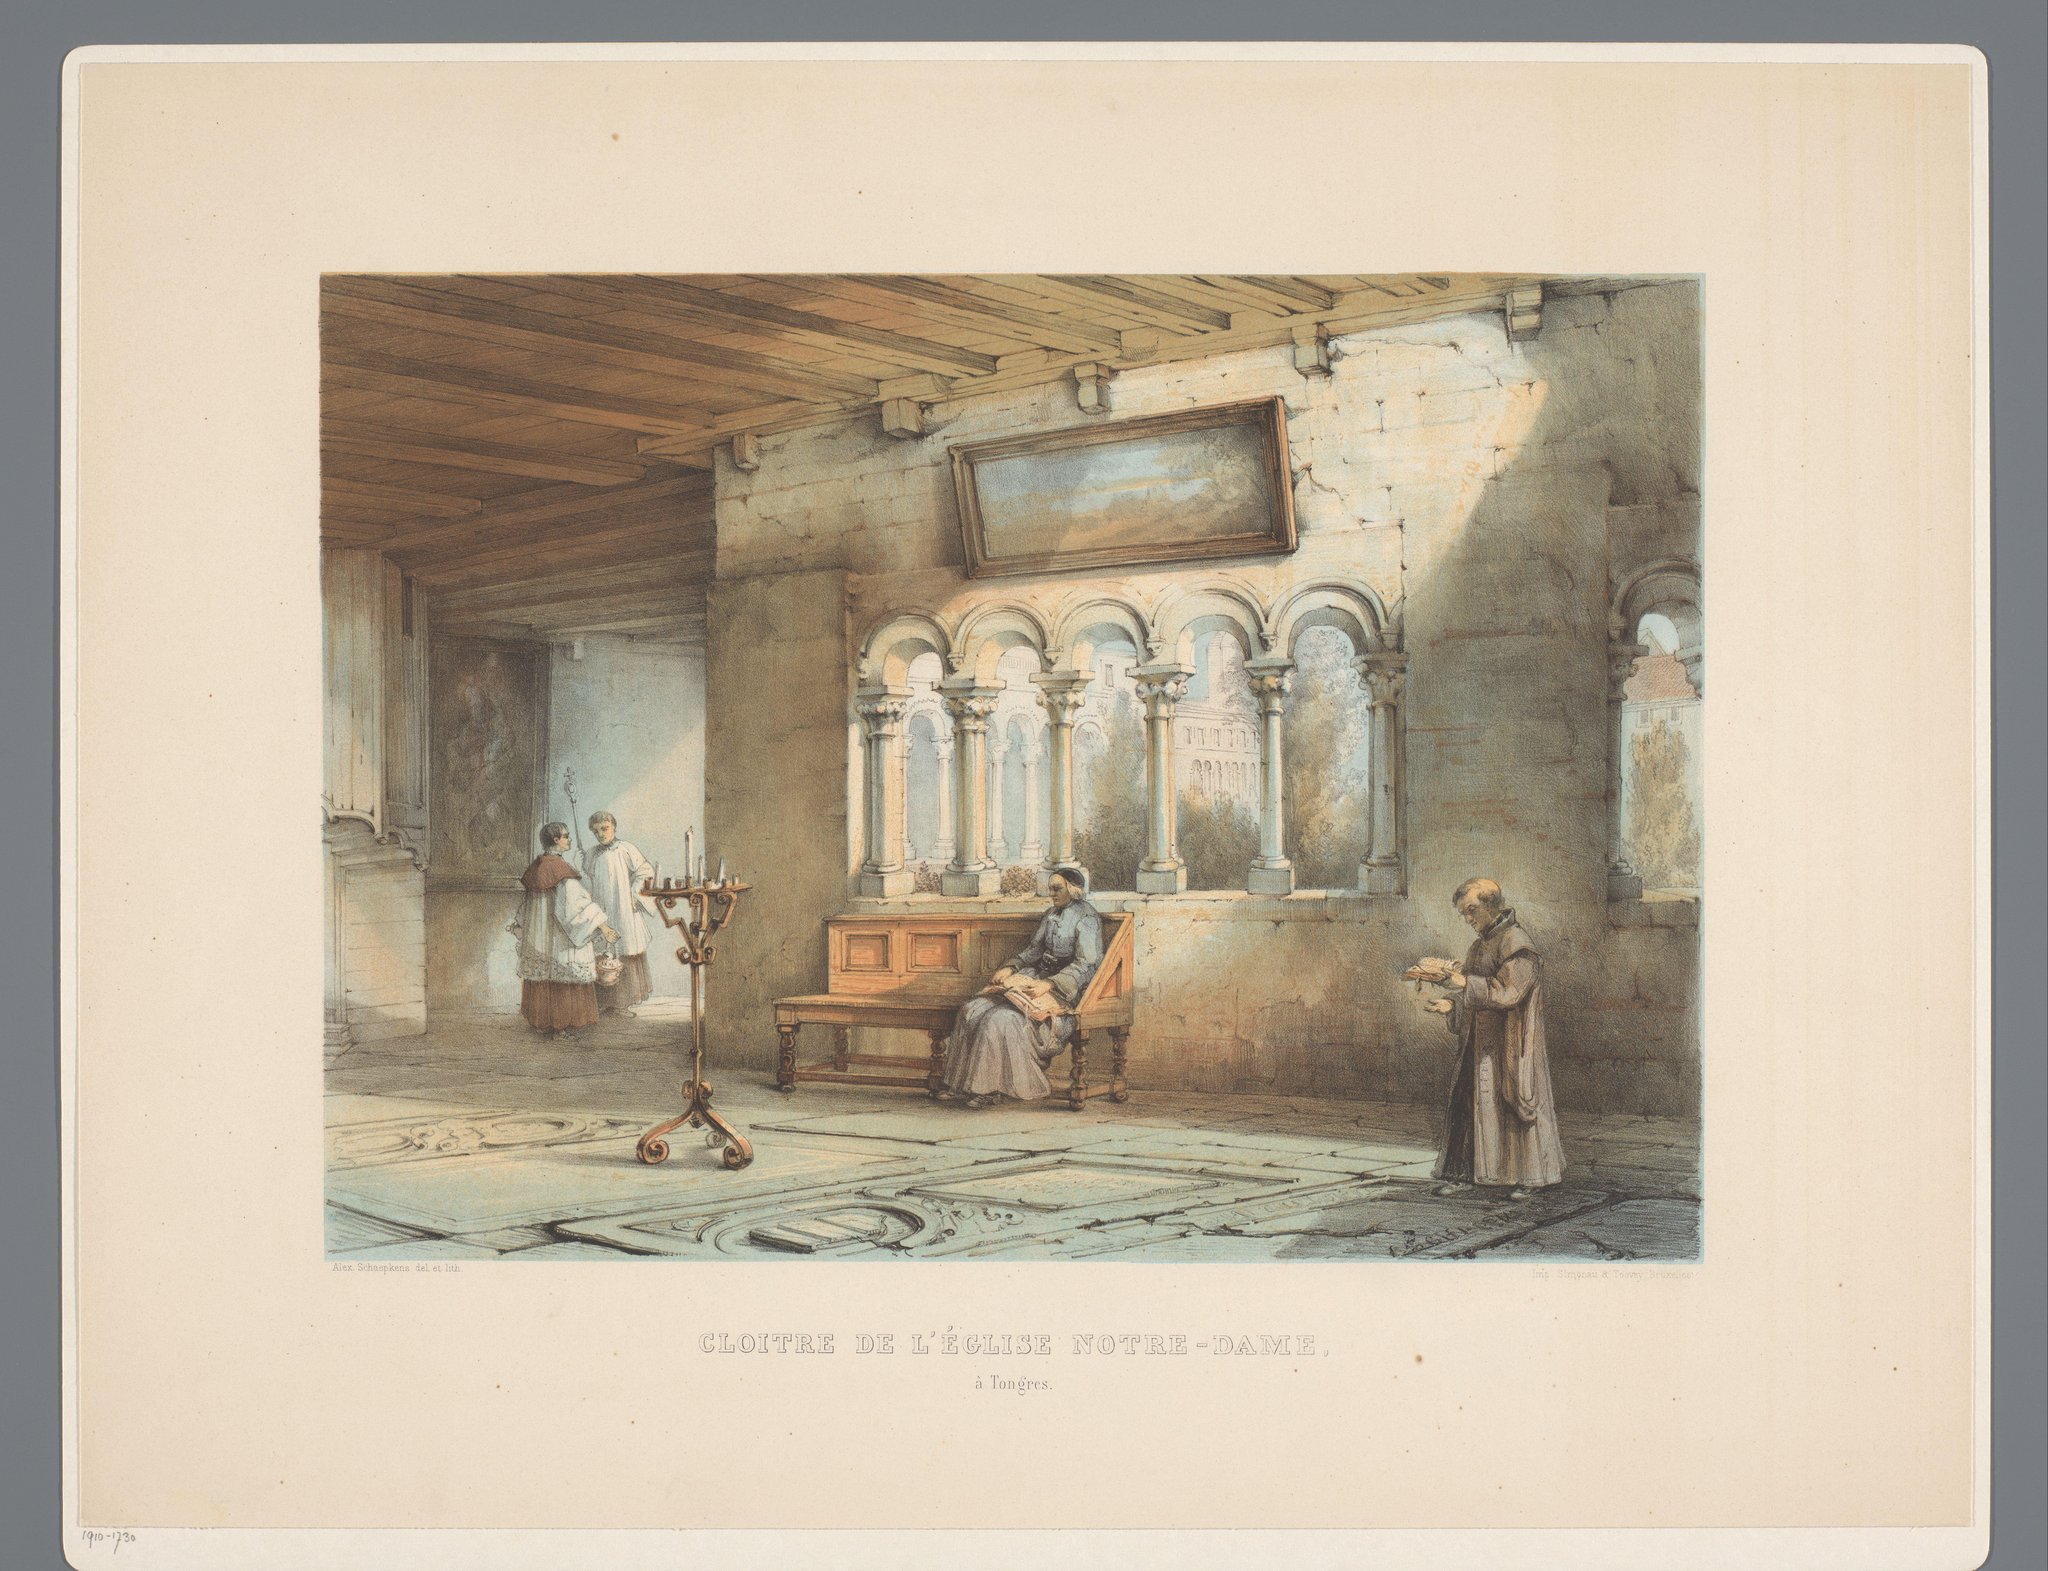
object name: print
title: Klooster van Onze-Lieve-Vrouwebasiliek te Tongeren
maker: alexander schaepkens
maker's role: draughtsman, print maker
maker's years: 1815-1899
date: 1855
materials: paper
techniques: lithograph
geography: brussels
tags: cloisters ~ monastery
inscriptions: collector's mark: Lugt 2228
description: Twee religieuzen, een man zittend op een bank en een monnik lezend in een boek in de kloostergang van de Onze-Lieve-Vrouwebasiliek te Tongeren.